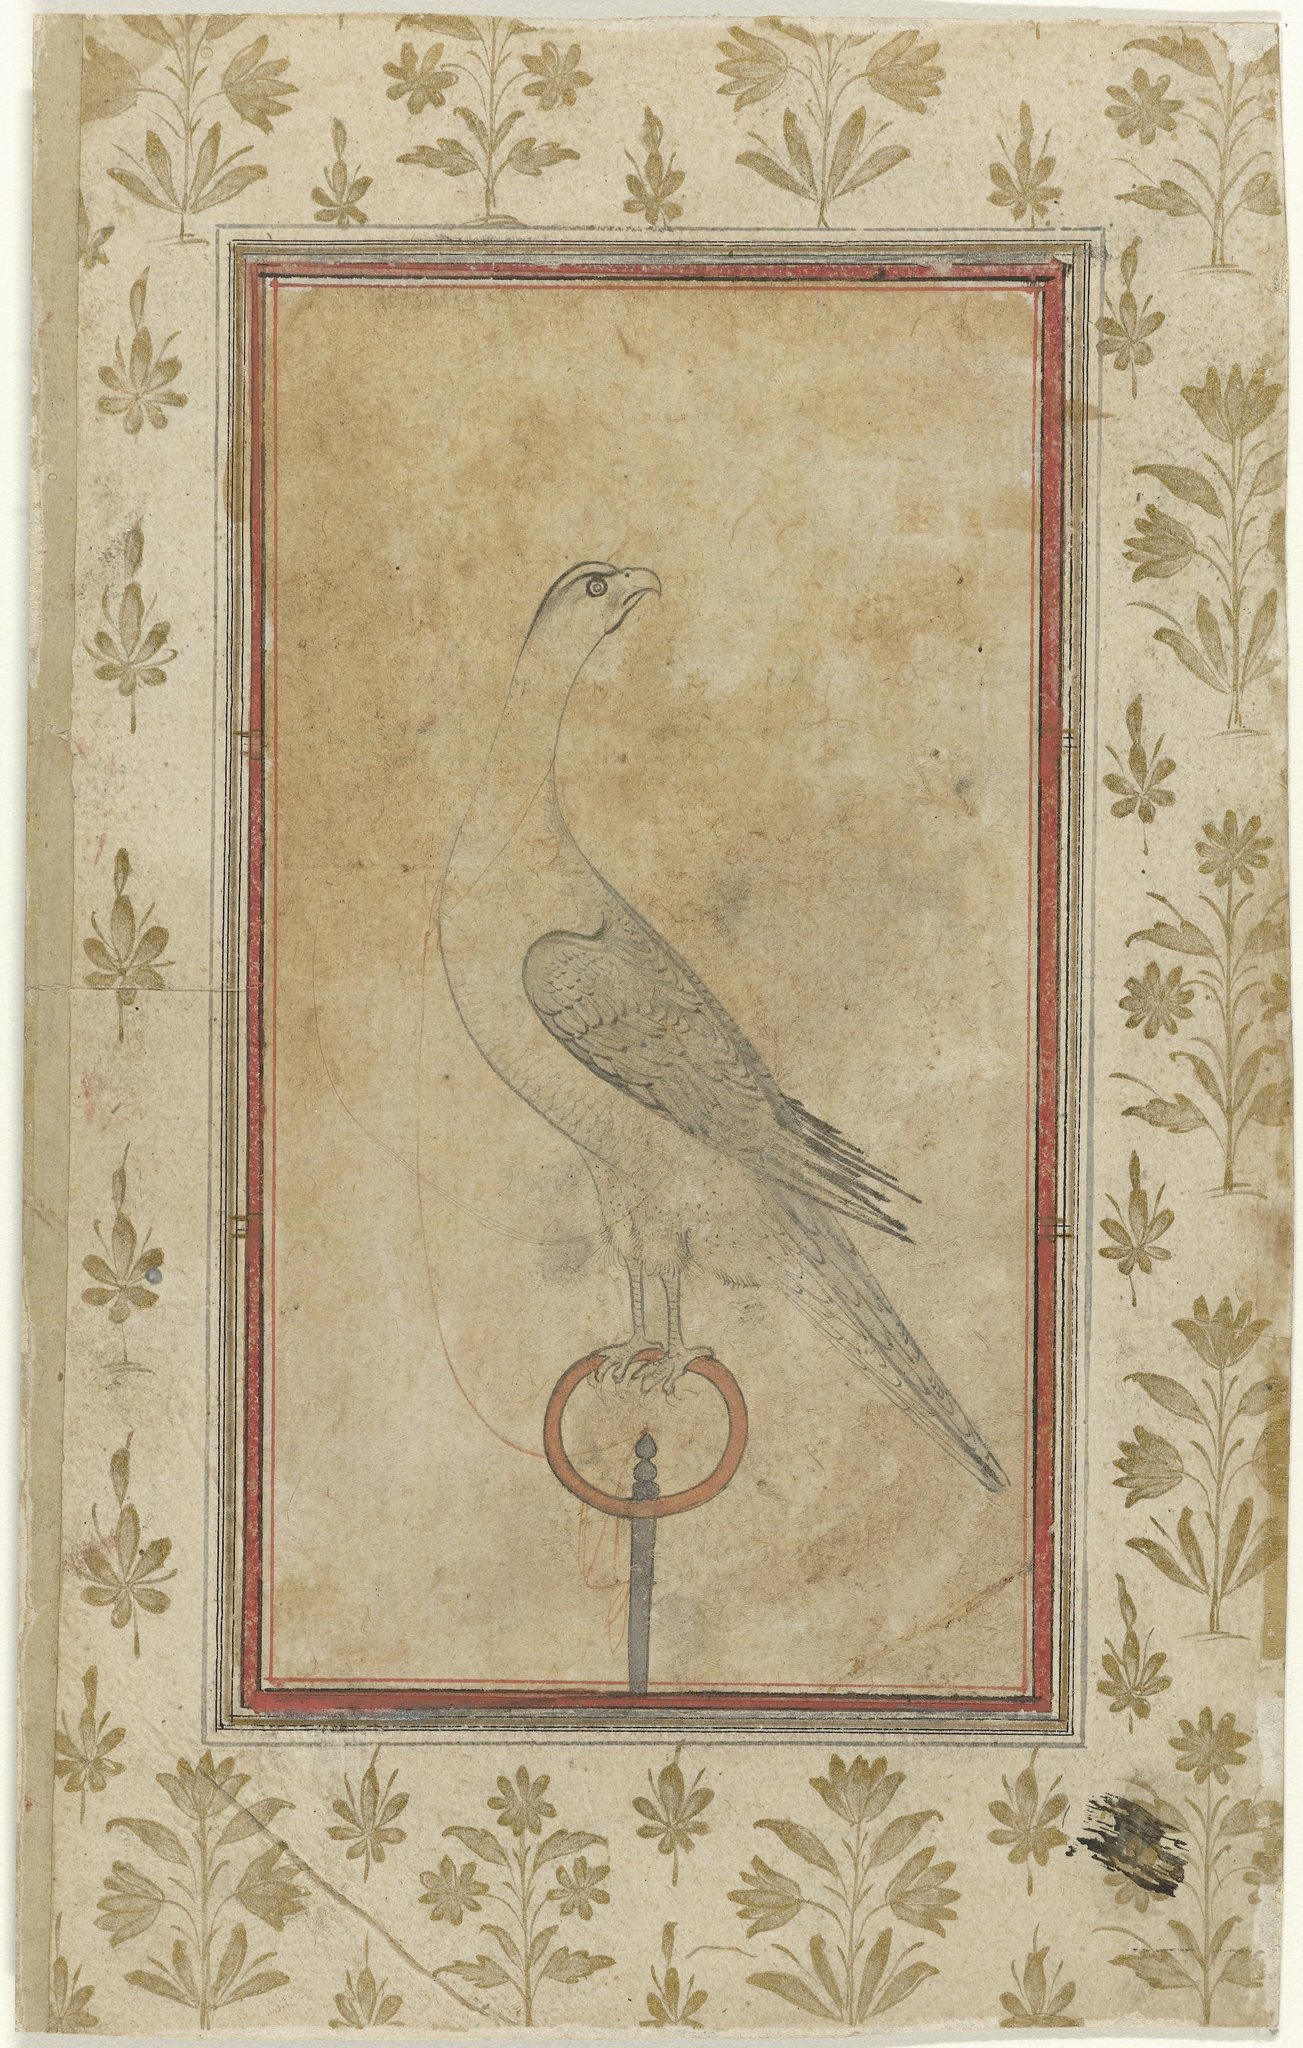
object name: indian miniature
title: Jachtvalk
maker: Anonymous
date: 1700-1800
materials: paint, paper, pencil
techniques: brush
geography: rajasthan